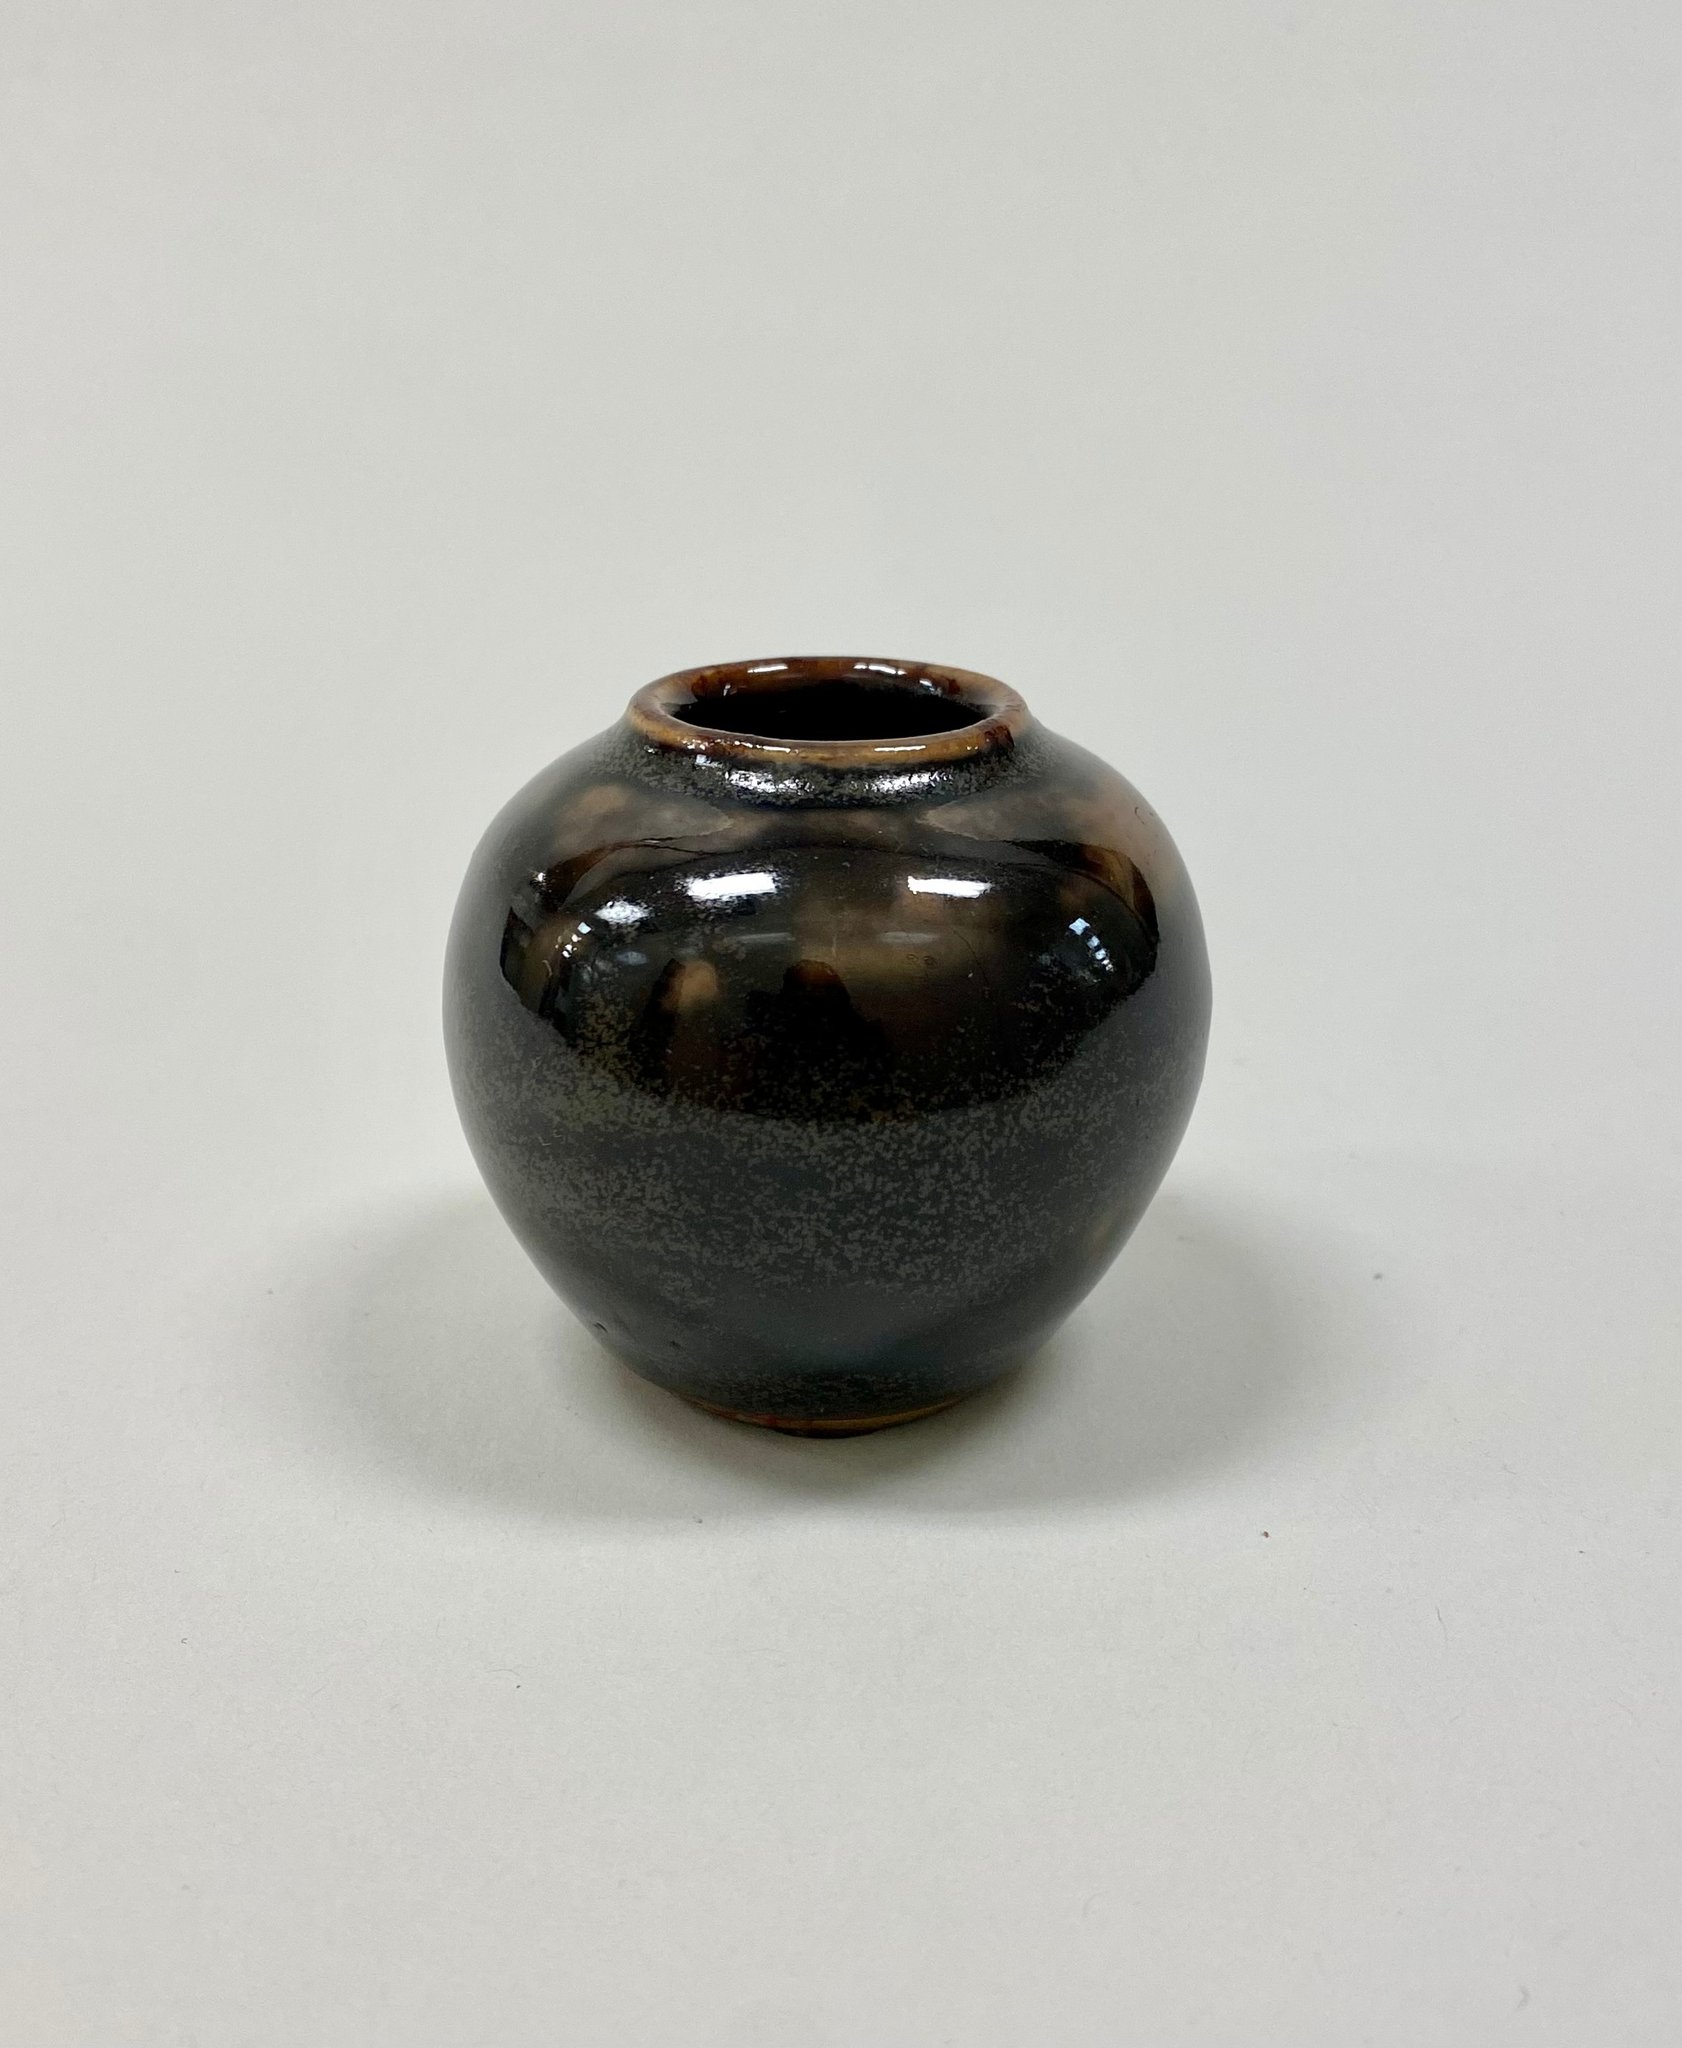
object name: jar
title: Miniature jar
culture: chinese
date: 1801-1833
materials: glaze, iron, porcelain